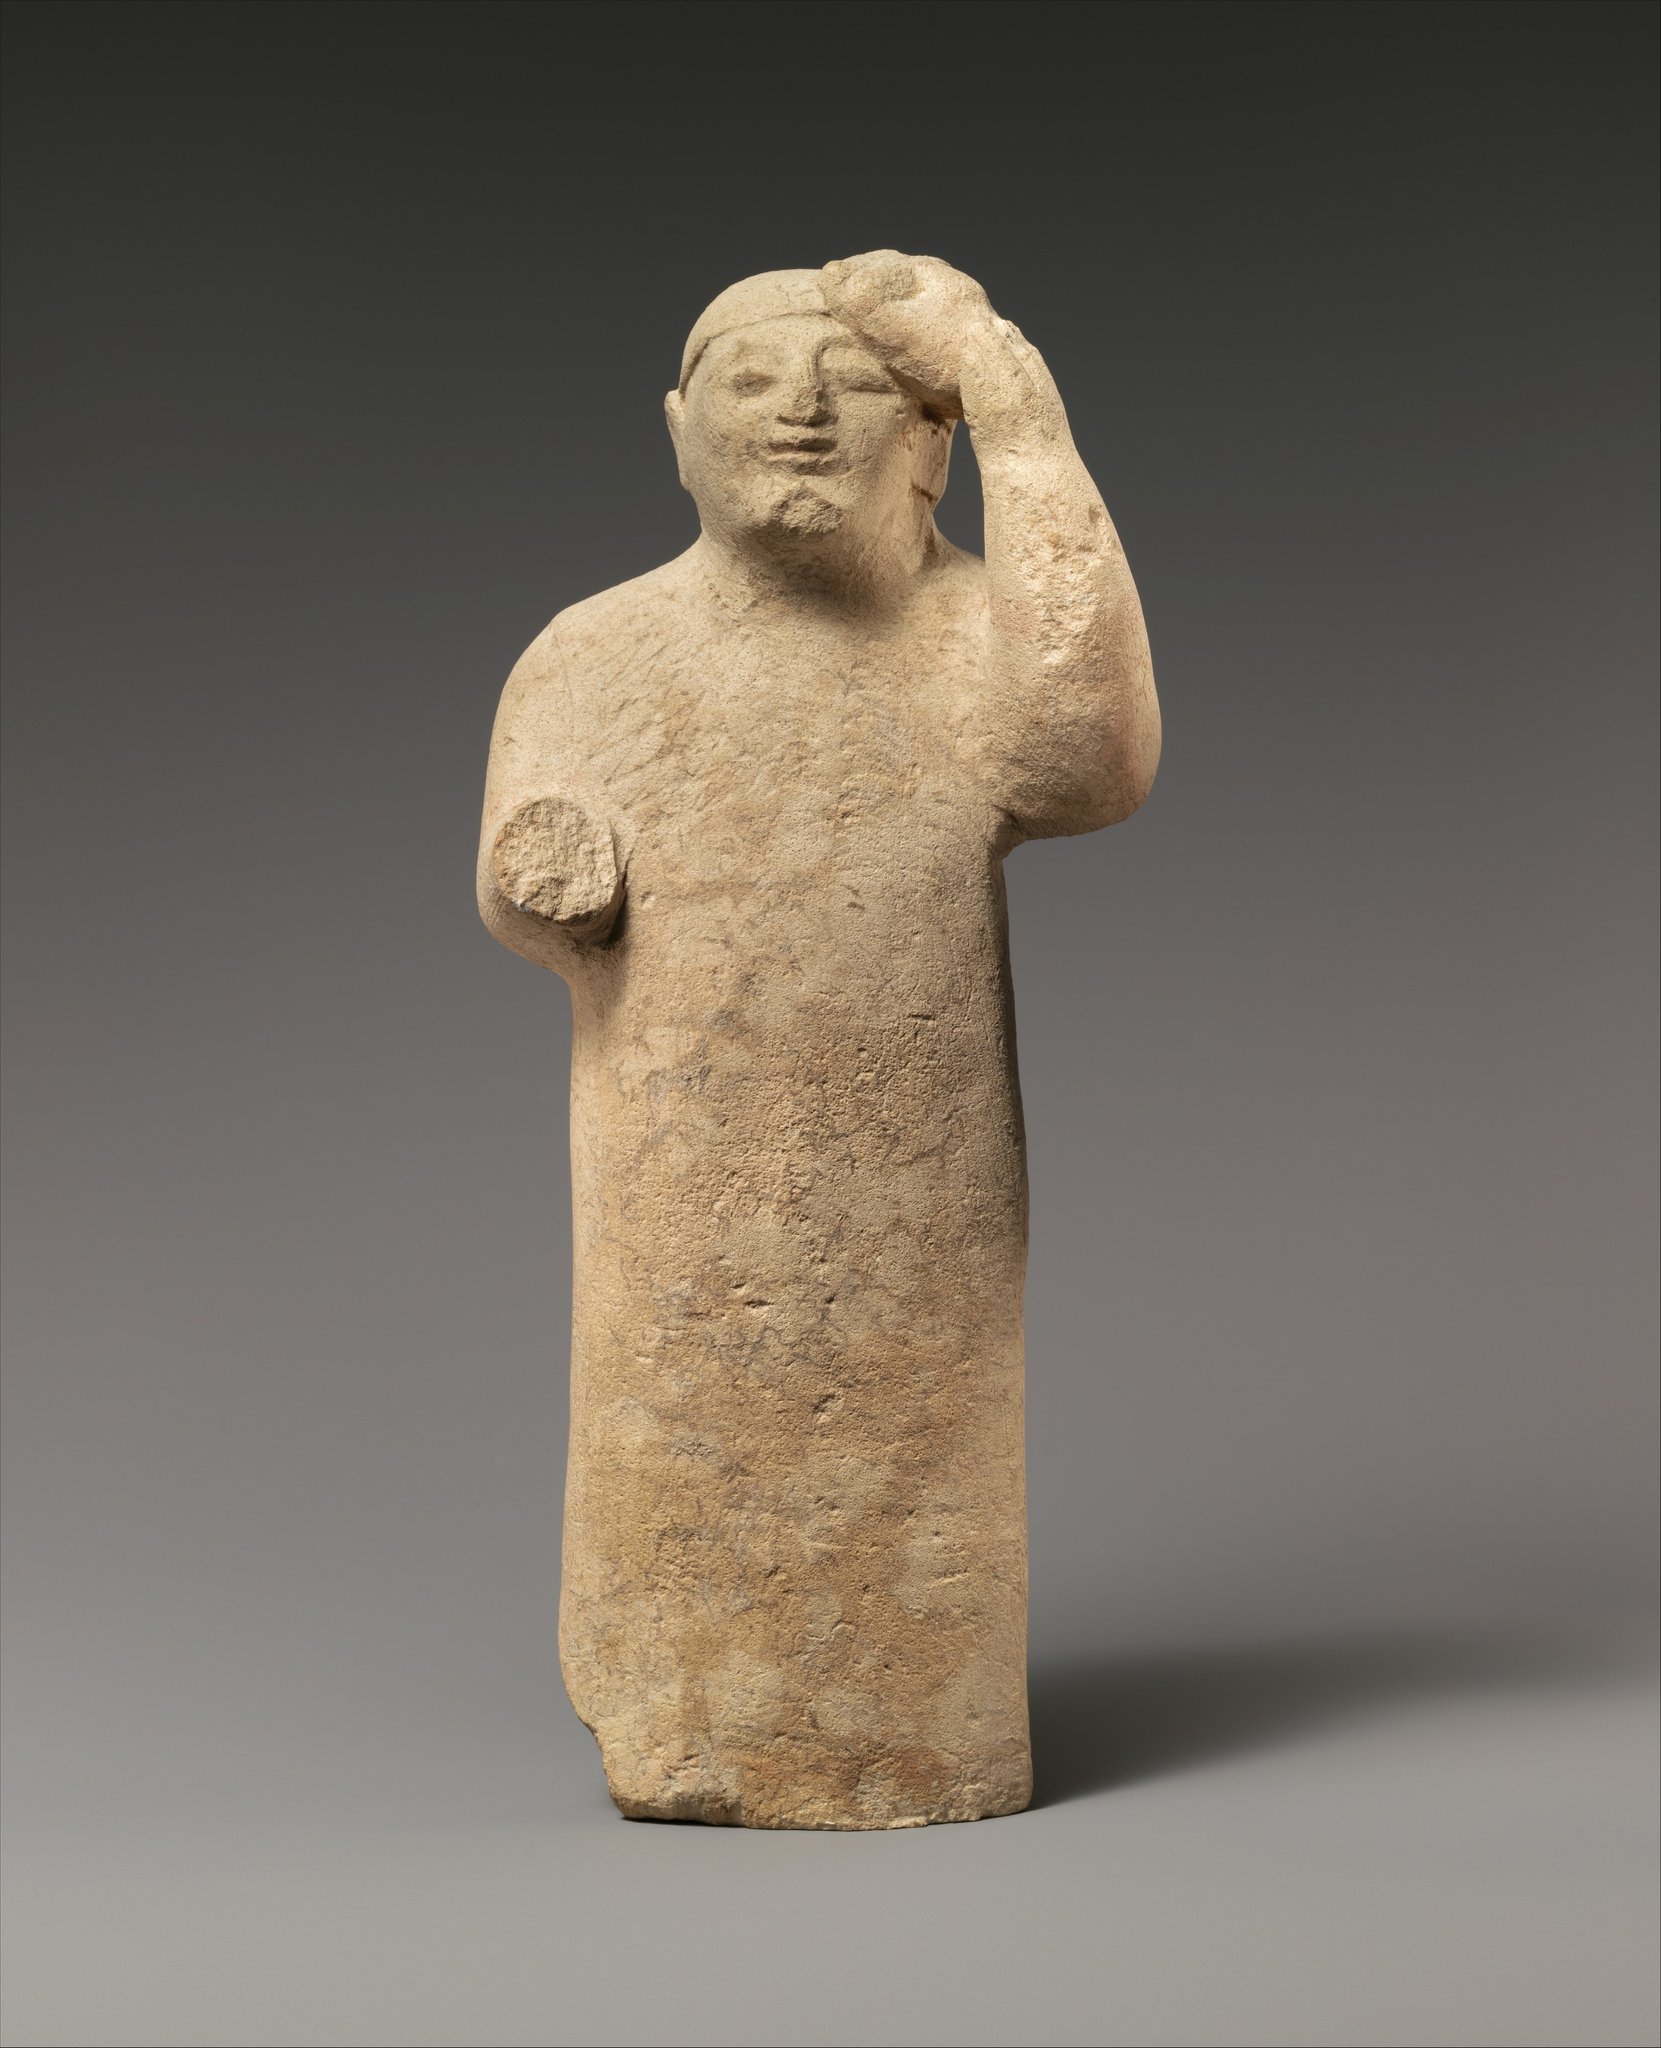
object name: statuette of a figure with a mask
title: Limestone figure holding a mask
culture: cypriot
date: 534-501 BCE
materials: limestone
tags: masks,men